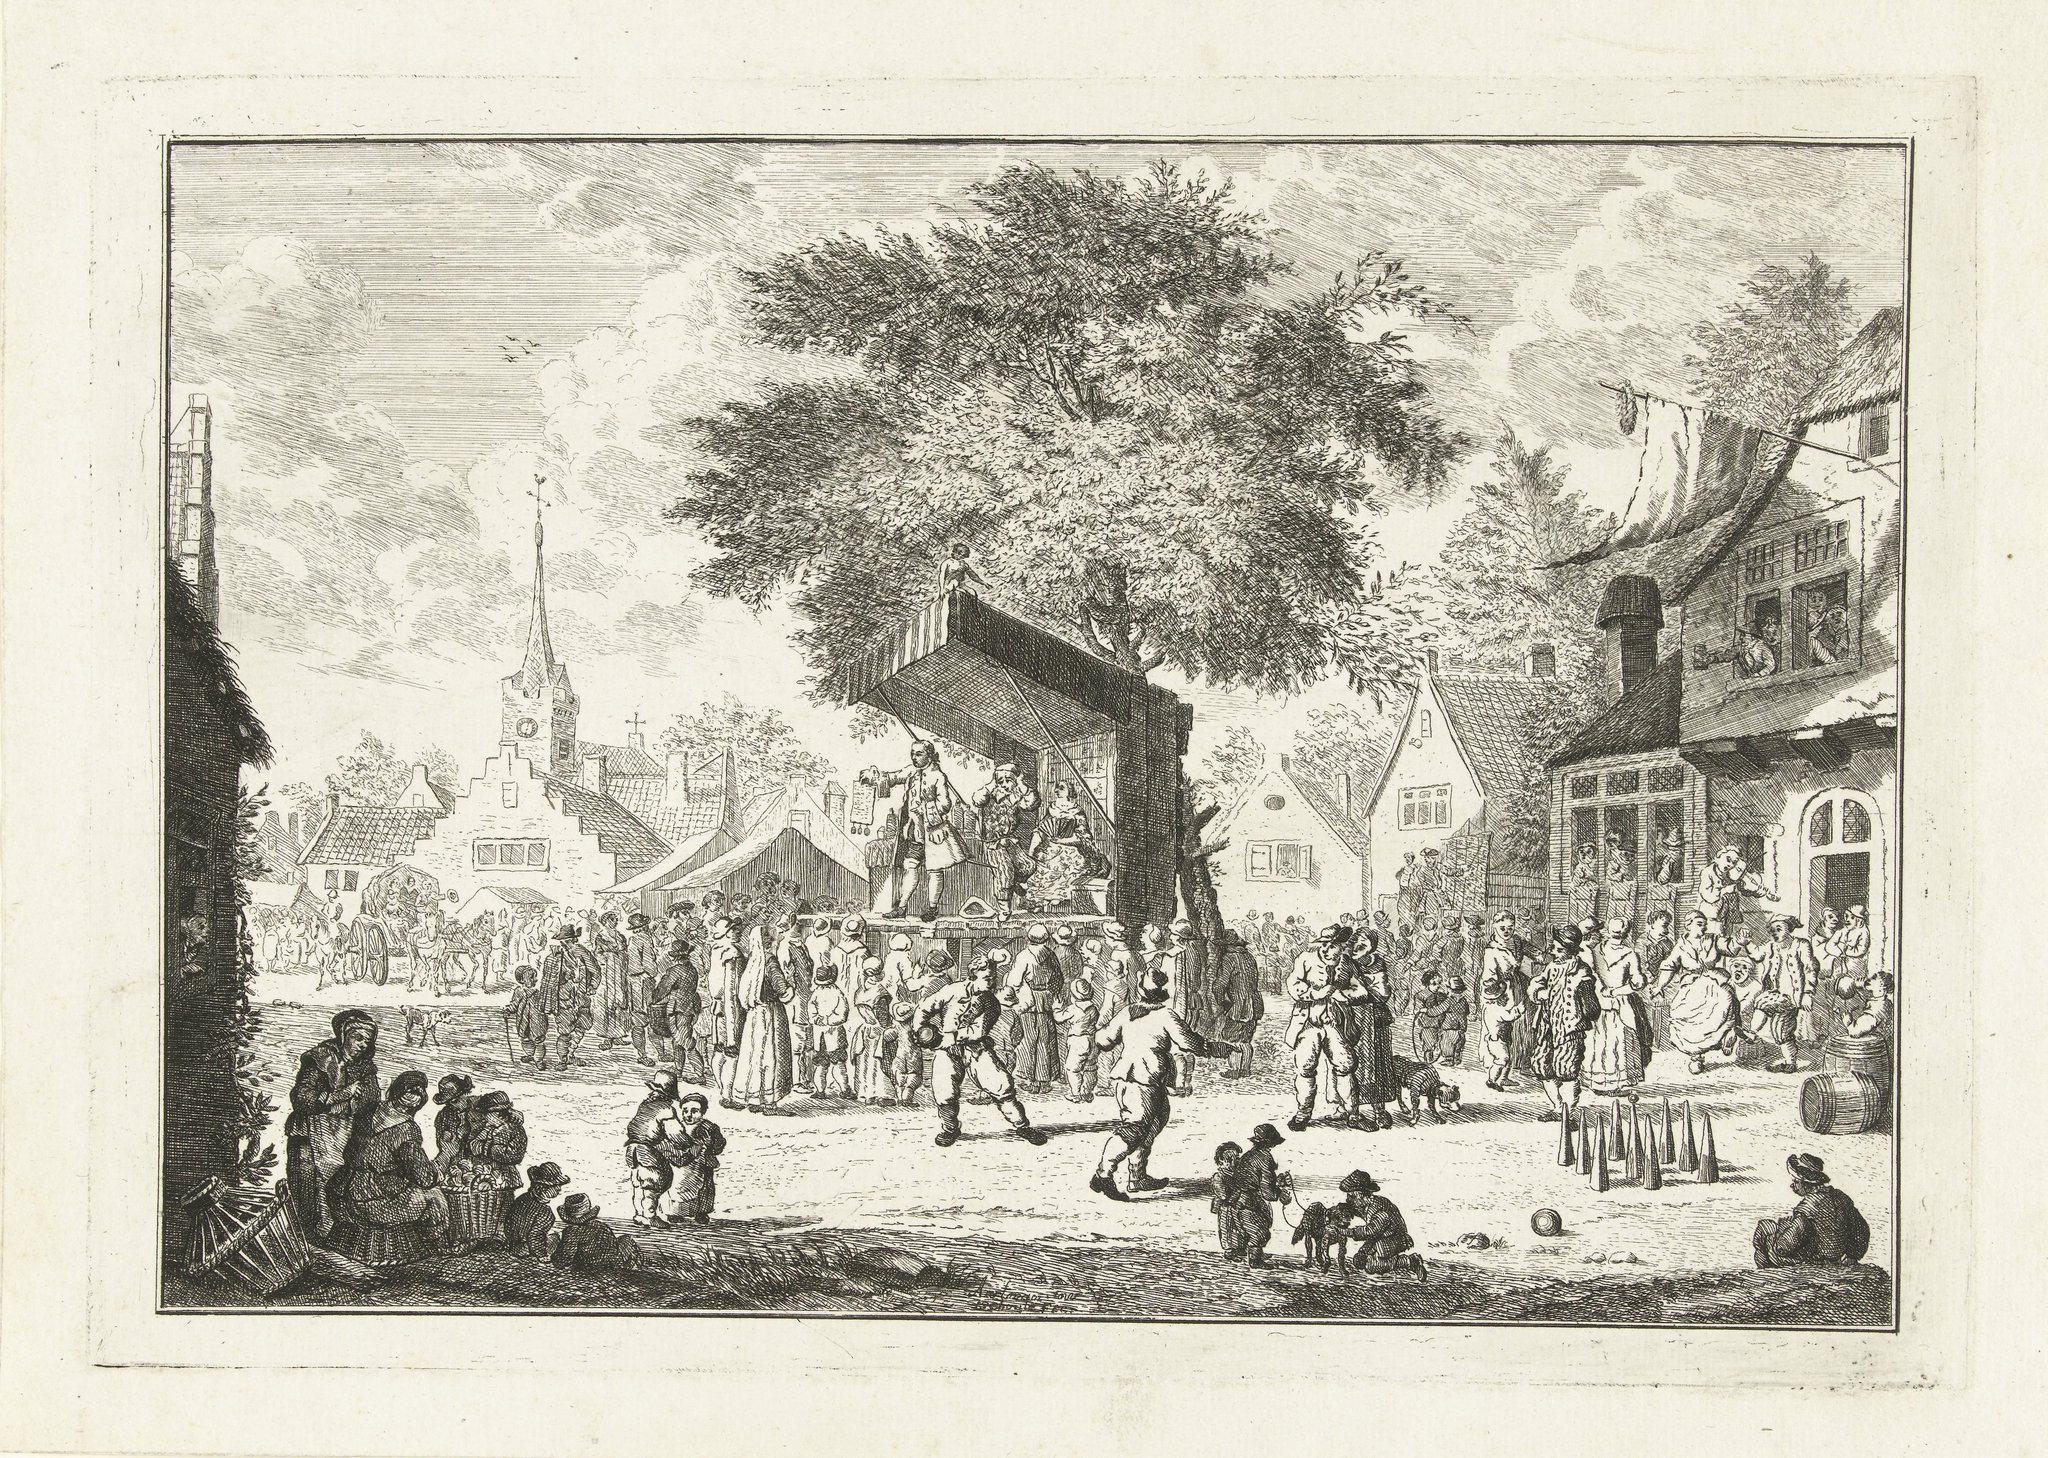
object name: print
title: Boerenkermis in het dorp, ca. 1750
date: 1740-1760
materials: paper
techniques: etching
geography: northern netherlands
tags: quack, charlatan, mountebank, 'saltimbanco', pleasure fair and circus, bowling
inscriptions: collector's mark: Lugt 2228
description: Boerenkermis in het dorp, ca. 1750. Op een podium presenteert een kwakzalver zich, rechts een kegelspel en dansende boeren voor een herberg.